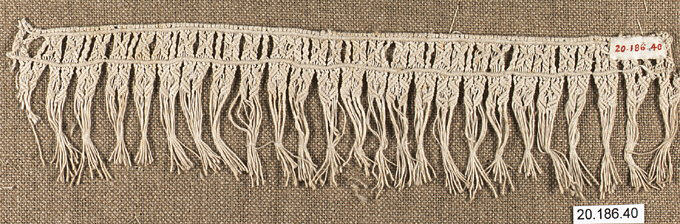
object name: edging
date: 1601-1700